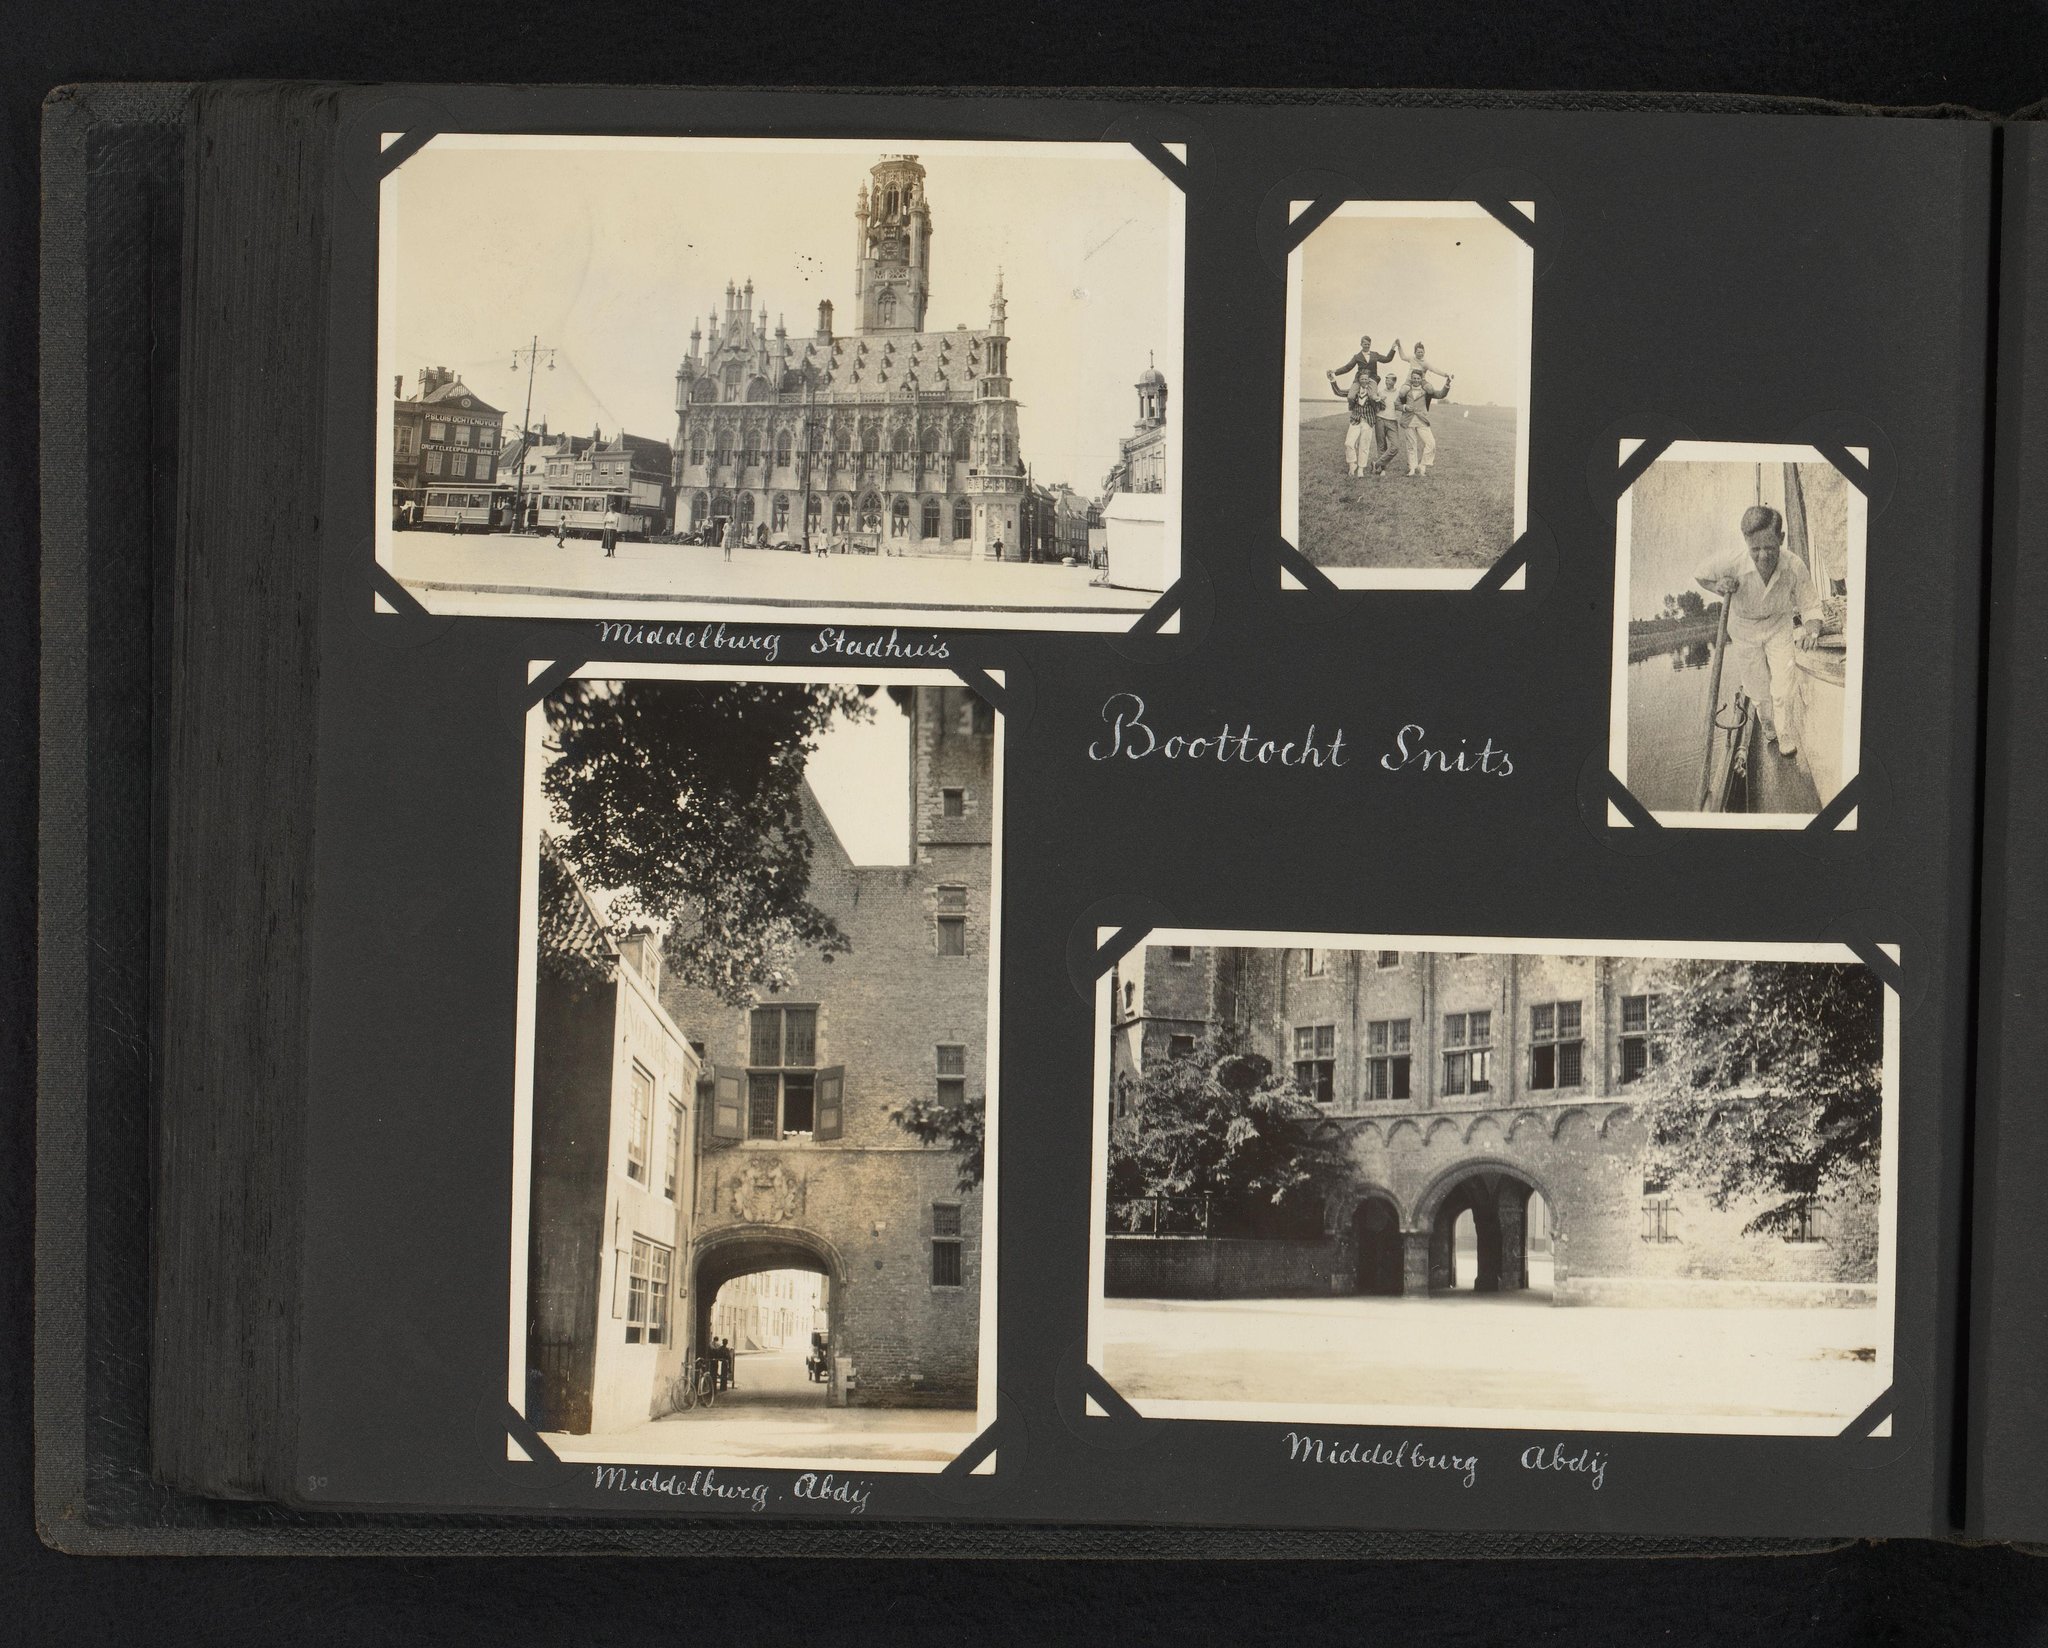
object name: album leaf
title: Boottocht Snits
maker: hendrik herman van den berg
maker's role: amateurfotograaf, jurist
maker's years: 1875-1944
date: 1907-1925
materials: paper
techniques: gelatin silver print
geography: zeeland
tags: sailing-ship, sailing-boat, abbey, monastery, convent ~ roman catholic church, townhall, middelburg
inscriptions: inscription: ‘Middelburg Stadhuis’, inscription: ‘Middelburg, Abdij’, inscription: ‘Middelburg Abdij’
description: Deze foto's maken deel uit van een album.